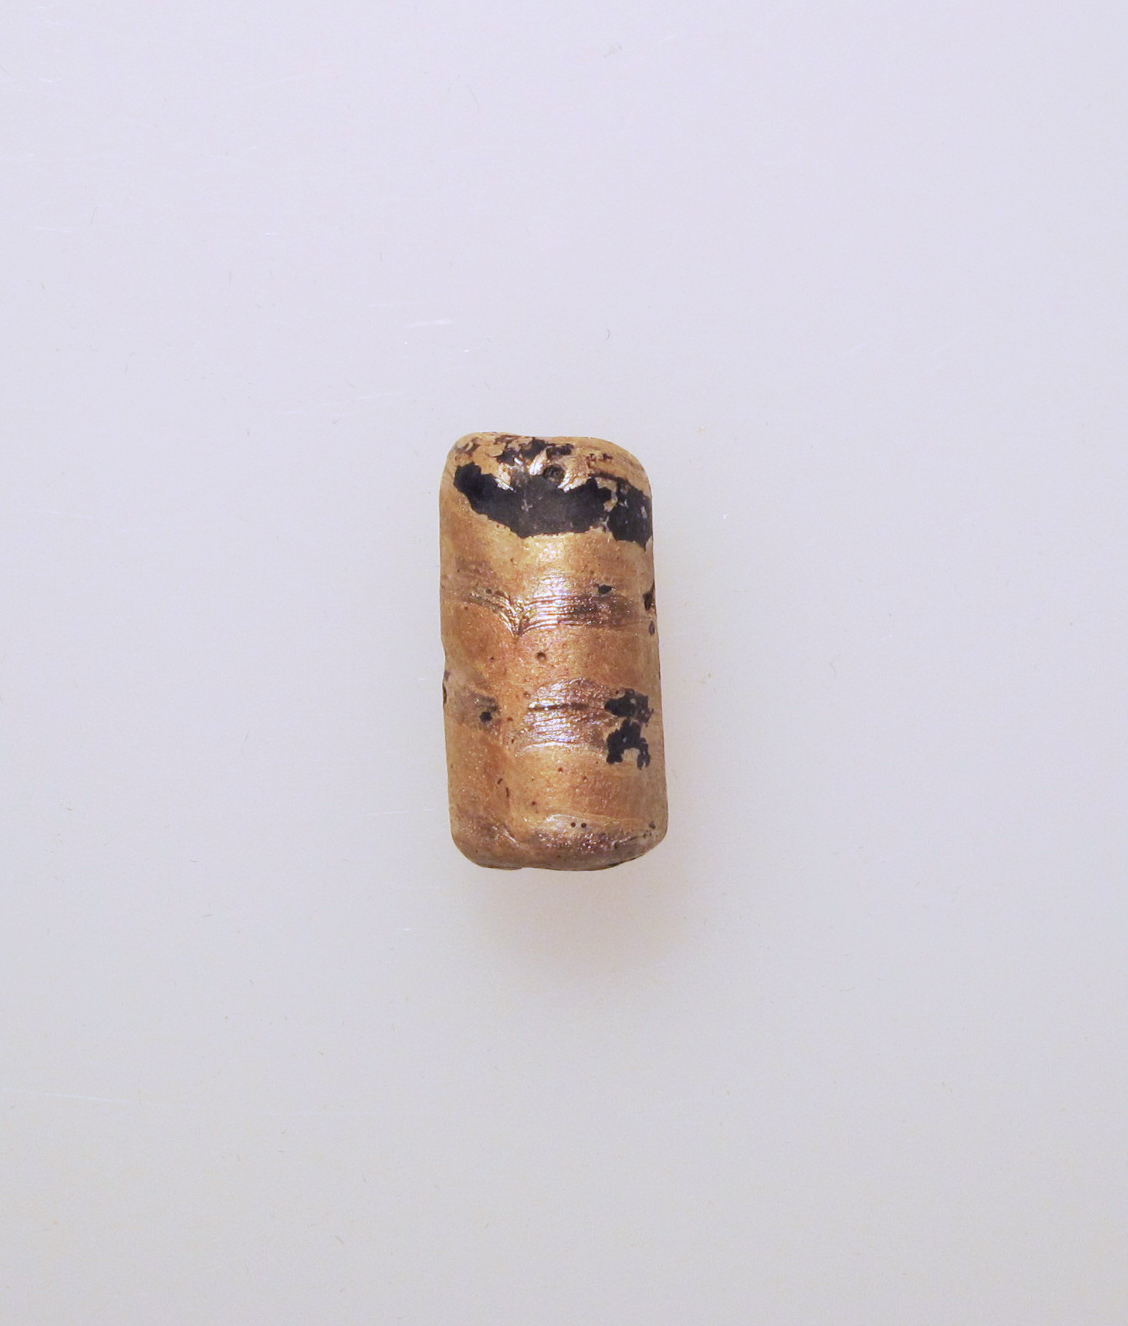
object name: bead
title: Glass cylindrical bead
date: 7000 BCE-330 CE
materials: glass